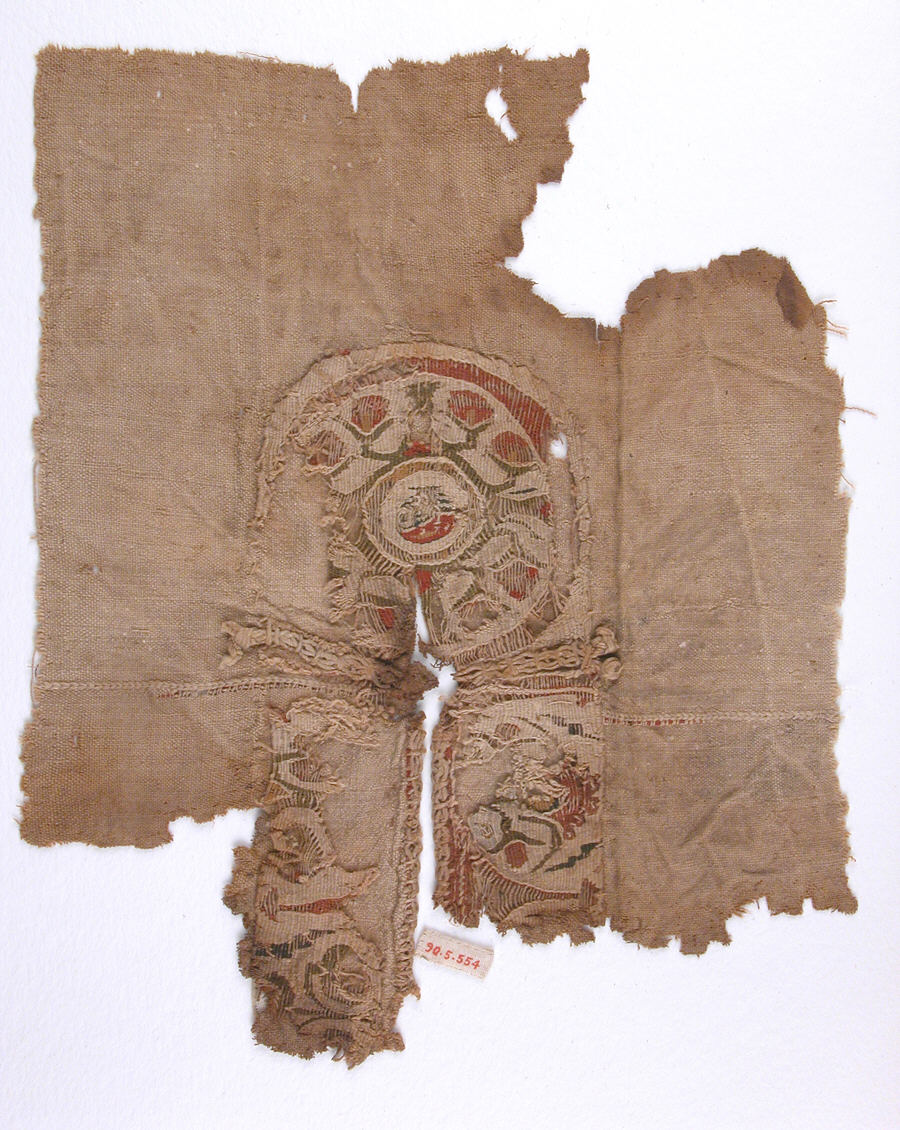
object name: textile fragment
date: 401-500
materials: linen, wool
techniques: weave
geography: egypt